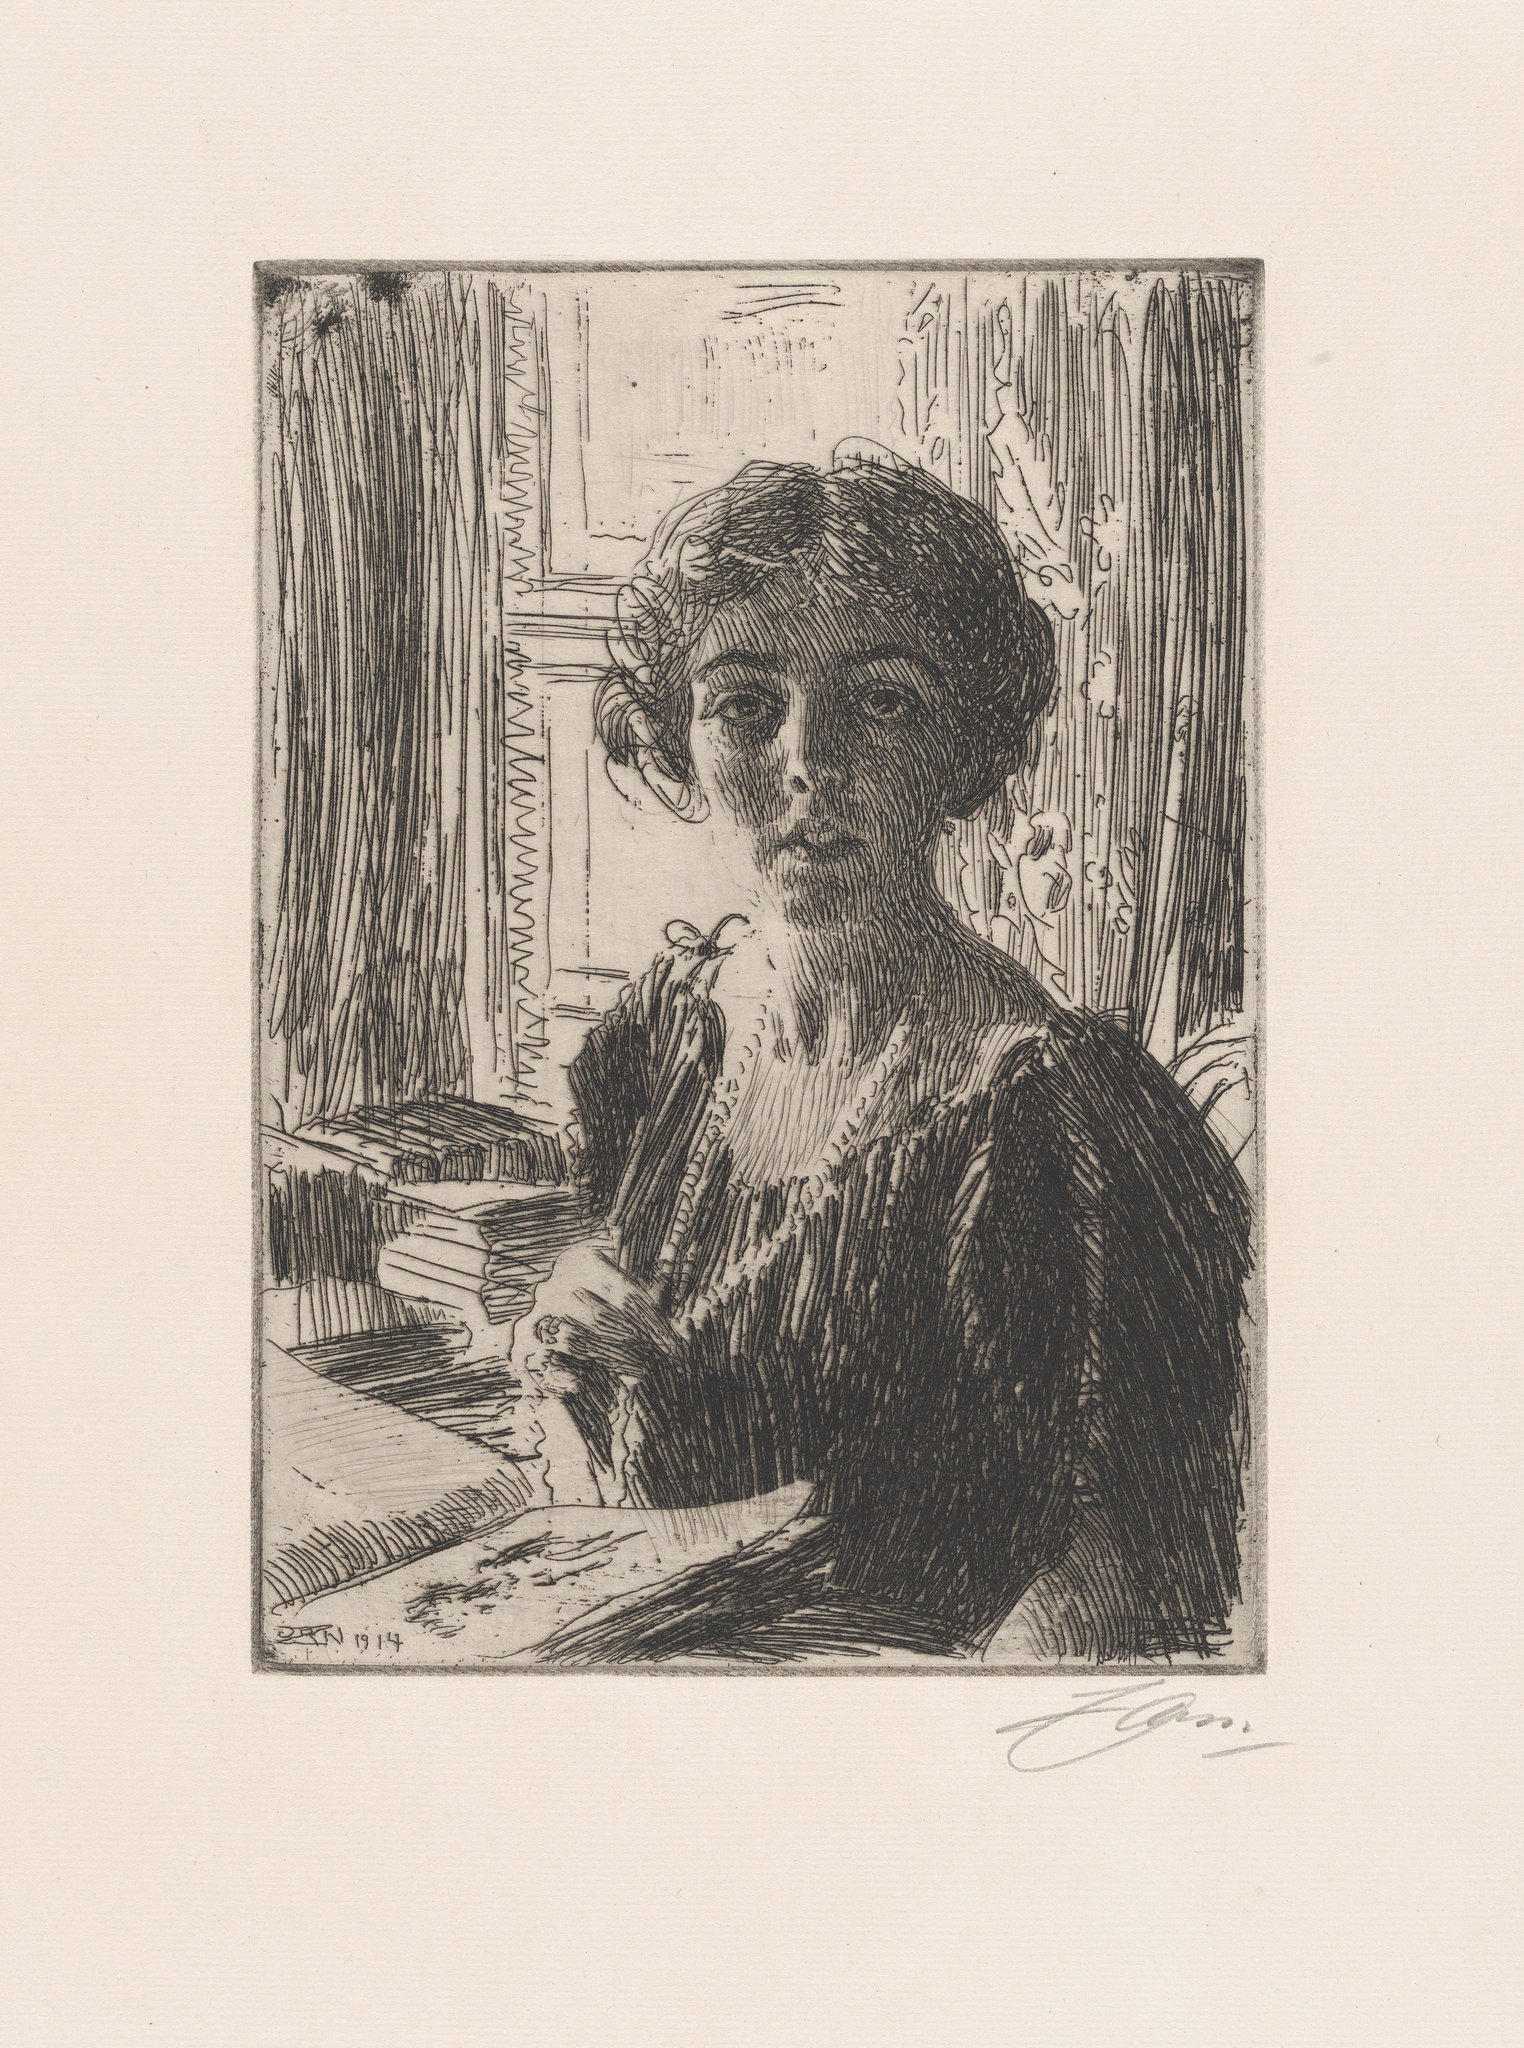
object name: print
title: The Crown Princess Margaret of Sweden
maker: anders zorn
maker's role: artist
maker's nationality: swedish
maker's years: 1860-1920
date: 1914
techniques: etching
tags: princesses,portraits,women